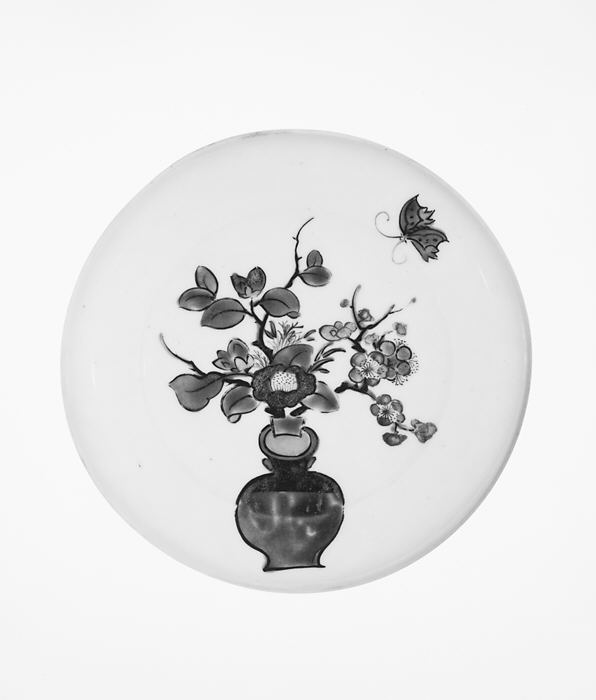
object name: dish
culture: japanese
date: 1615-1868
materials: enamel, porcelain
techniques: painting, polychrome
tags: butterflies,flowers,leaves